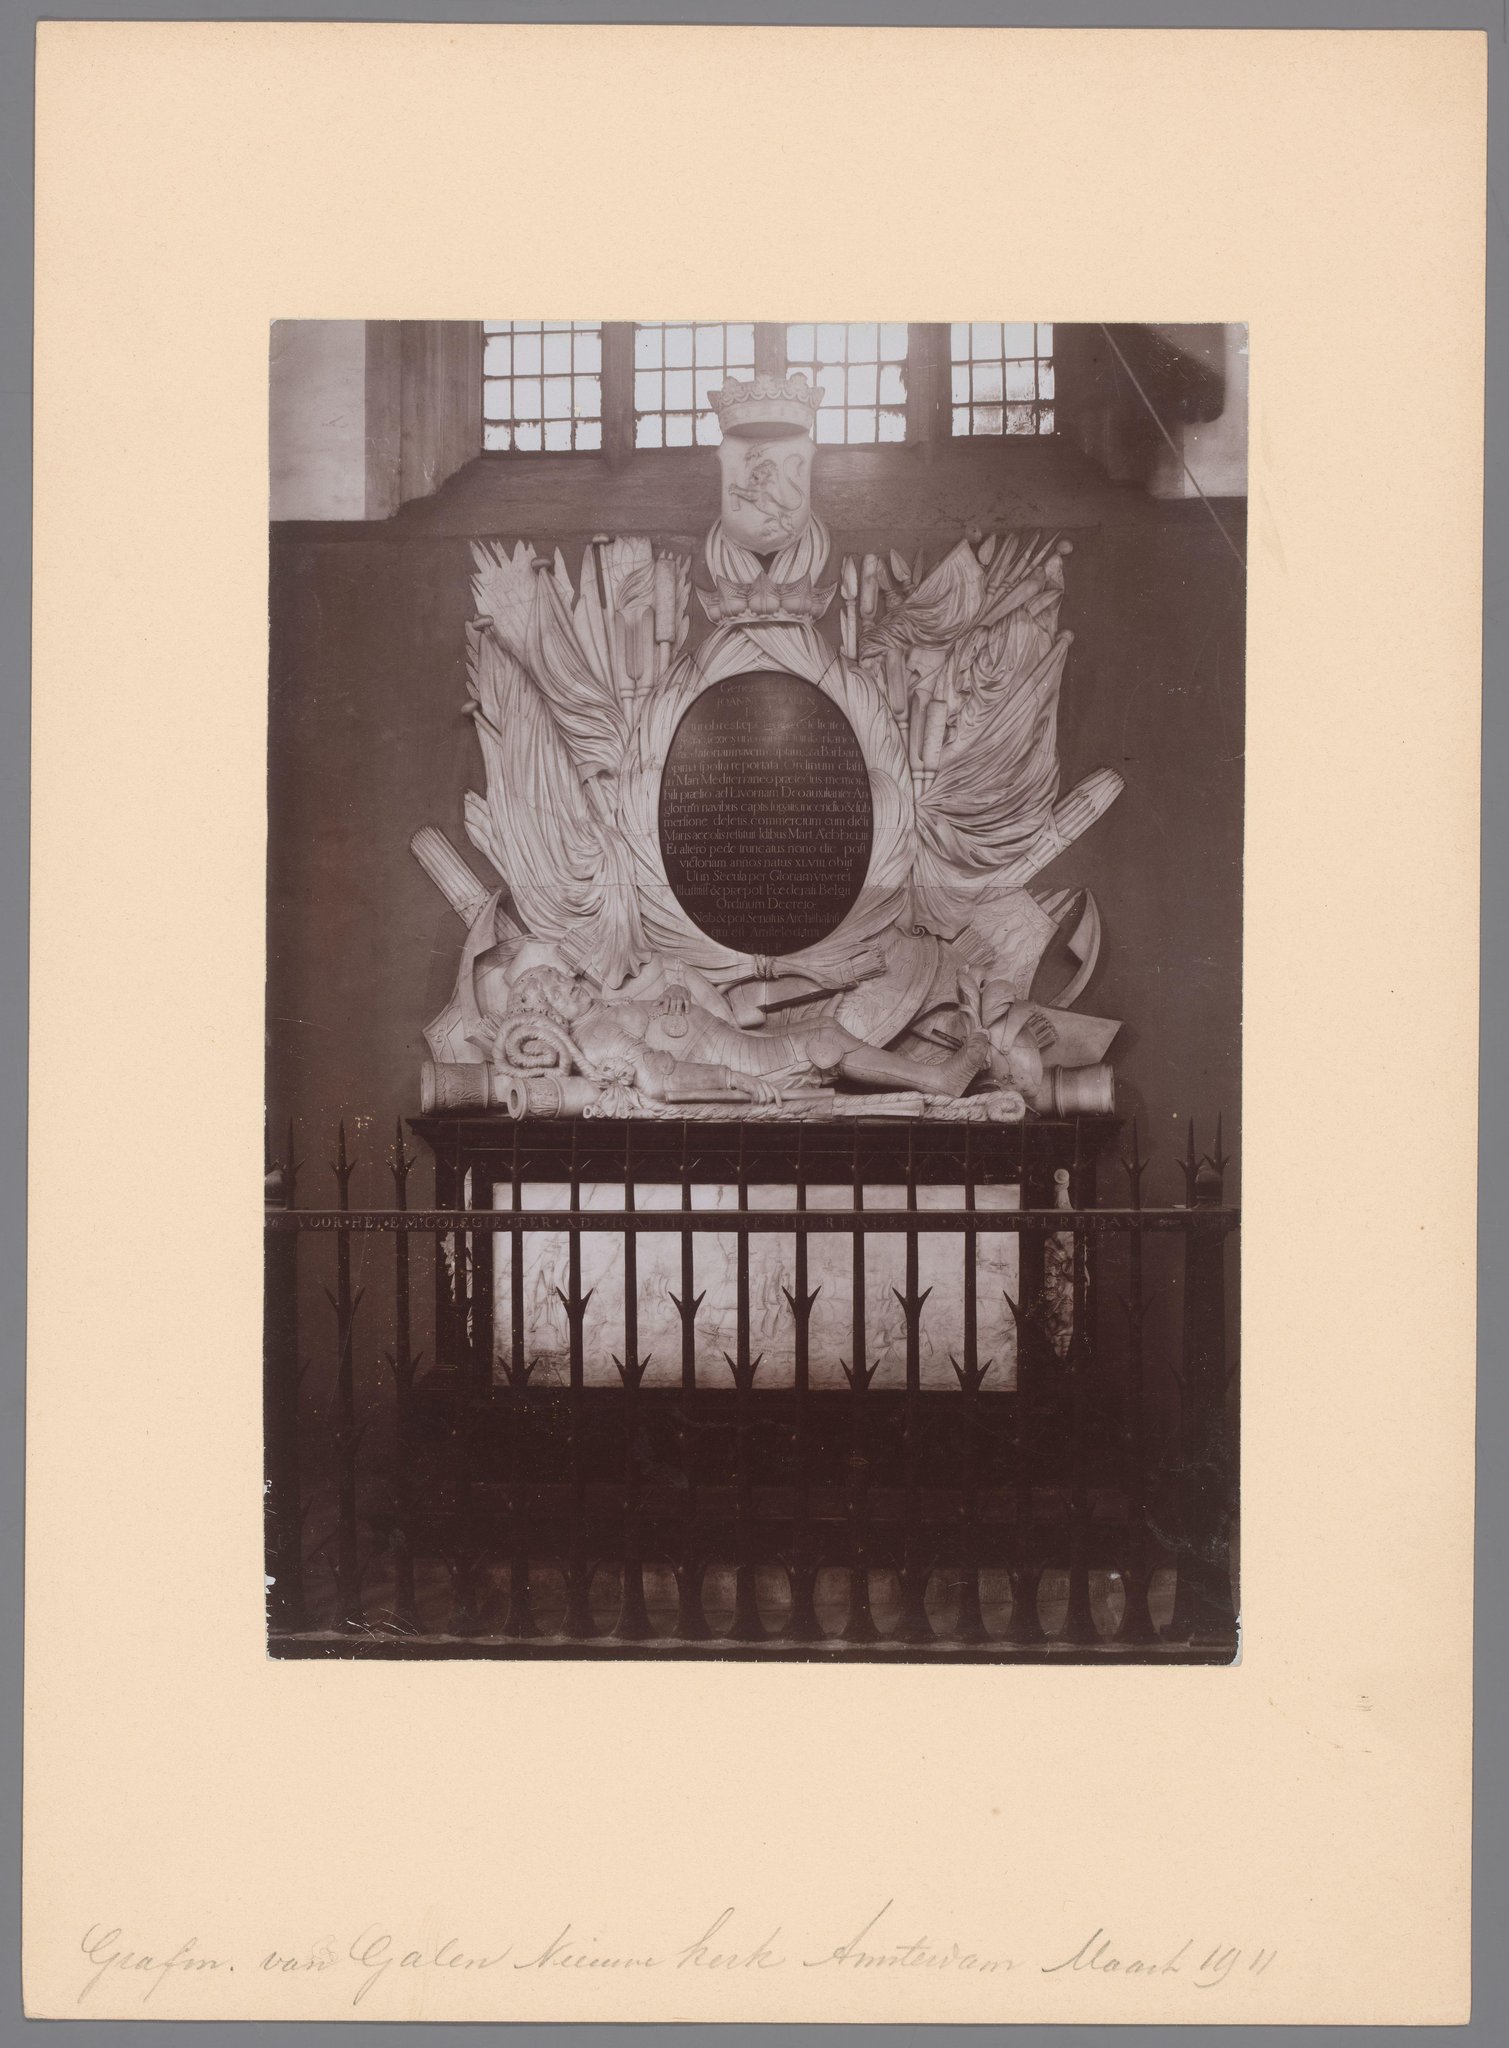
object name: photograph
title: Grafmonument van Jan van Galen in de Nieuwe Kerk te Amsterdam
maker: anoniem (monumentenzorg)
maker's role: fotograaf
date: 1911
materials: cardboard, photographic support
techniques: collodion silver print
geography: nieuwe kerk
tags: essen, interior of church, piece of sculpture, reproduction of a piece of sculpture, grave-building, monumental tomb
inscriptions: annotation: ‘Gram. van Galen Nieuwe kerk Amsterdam Maart 1911’